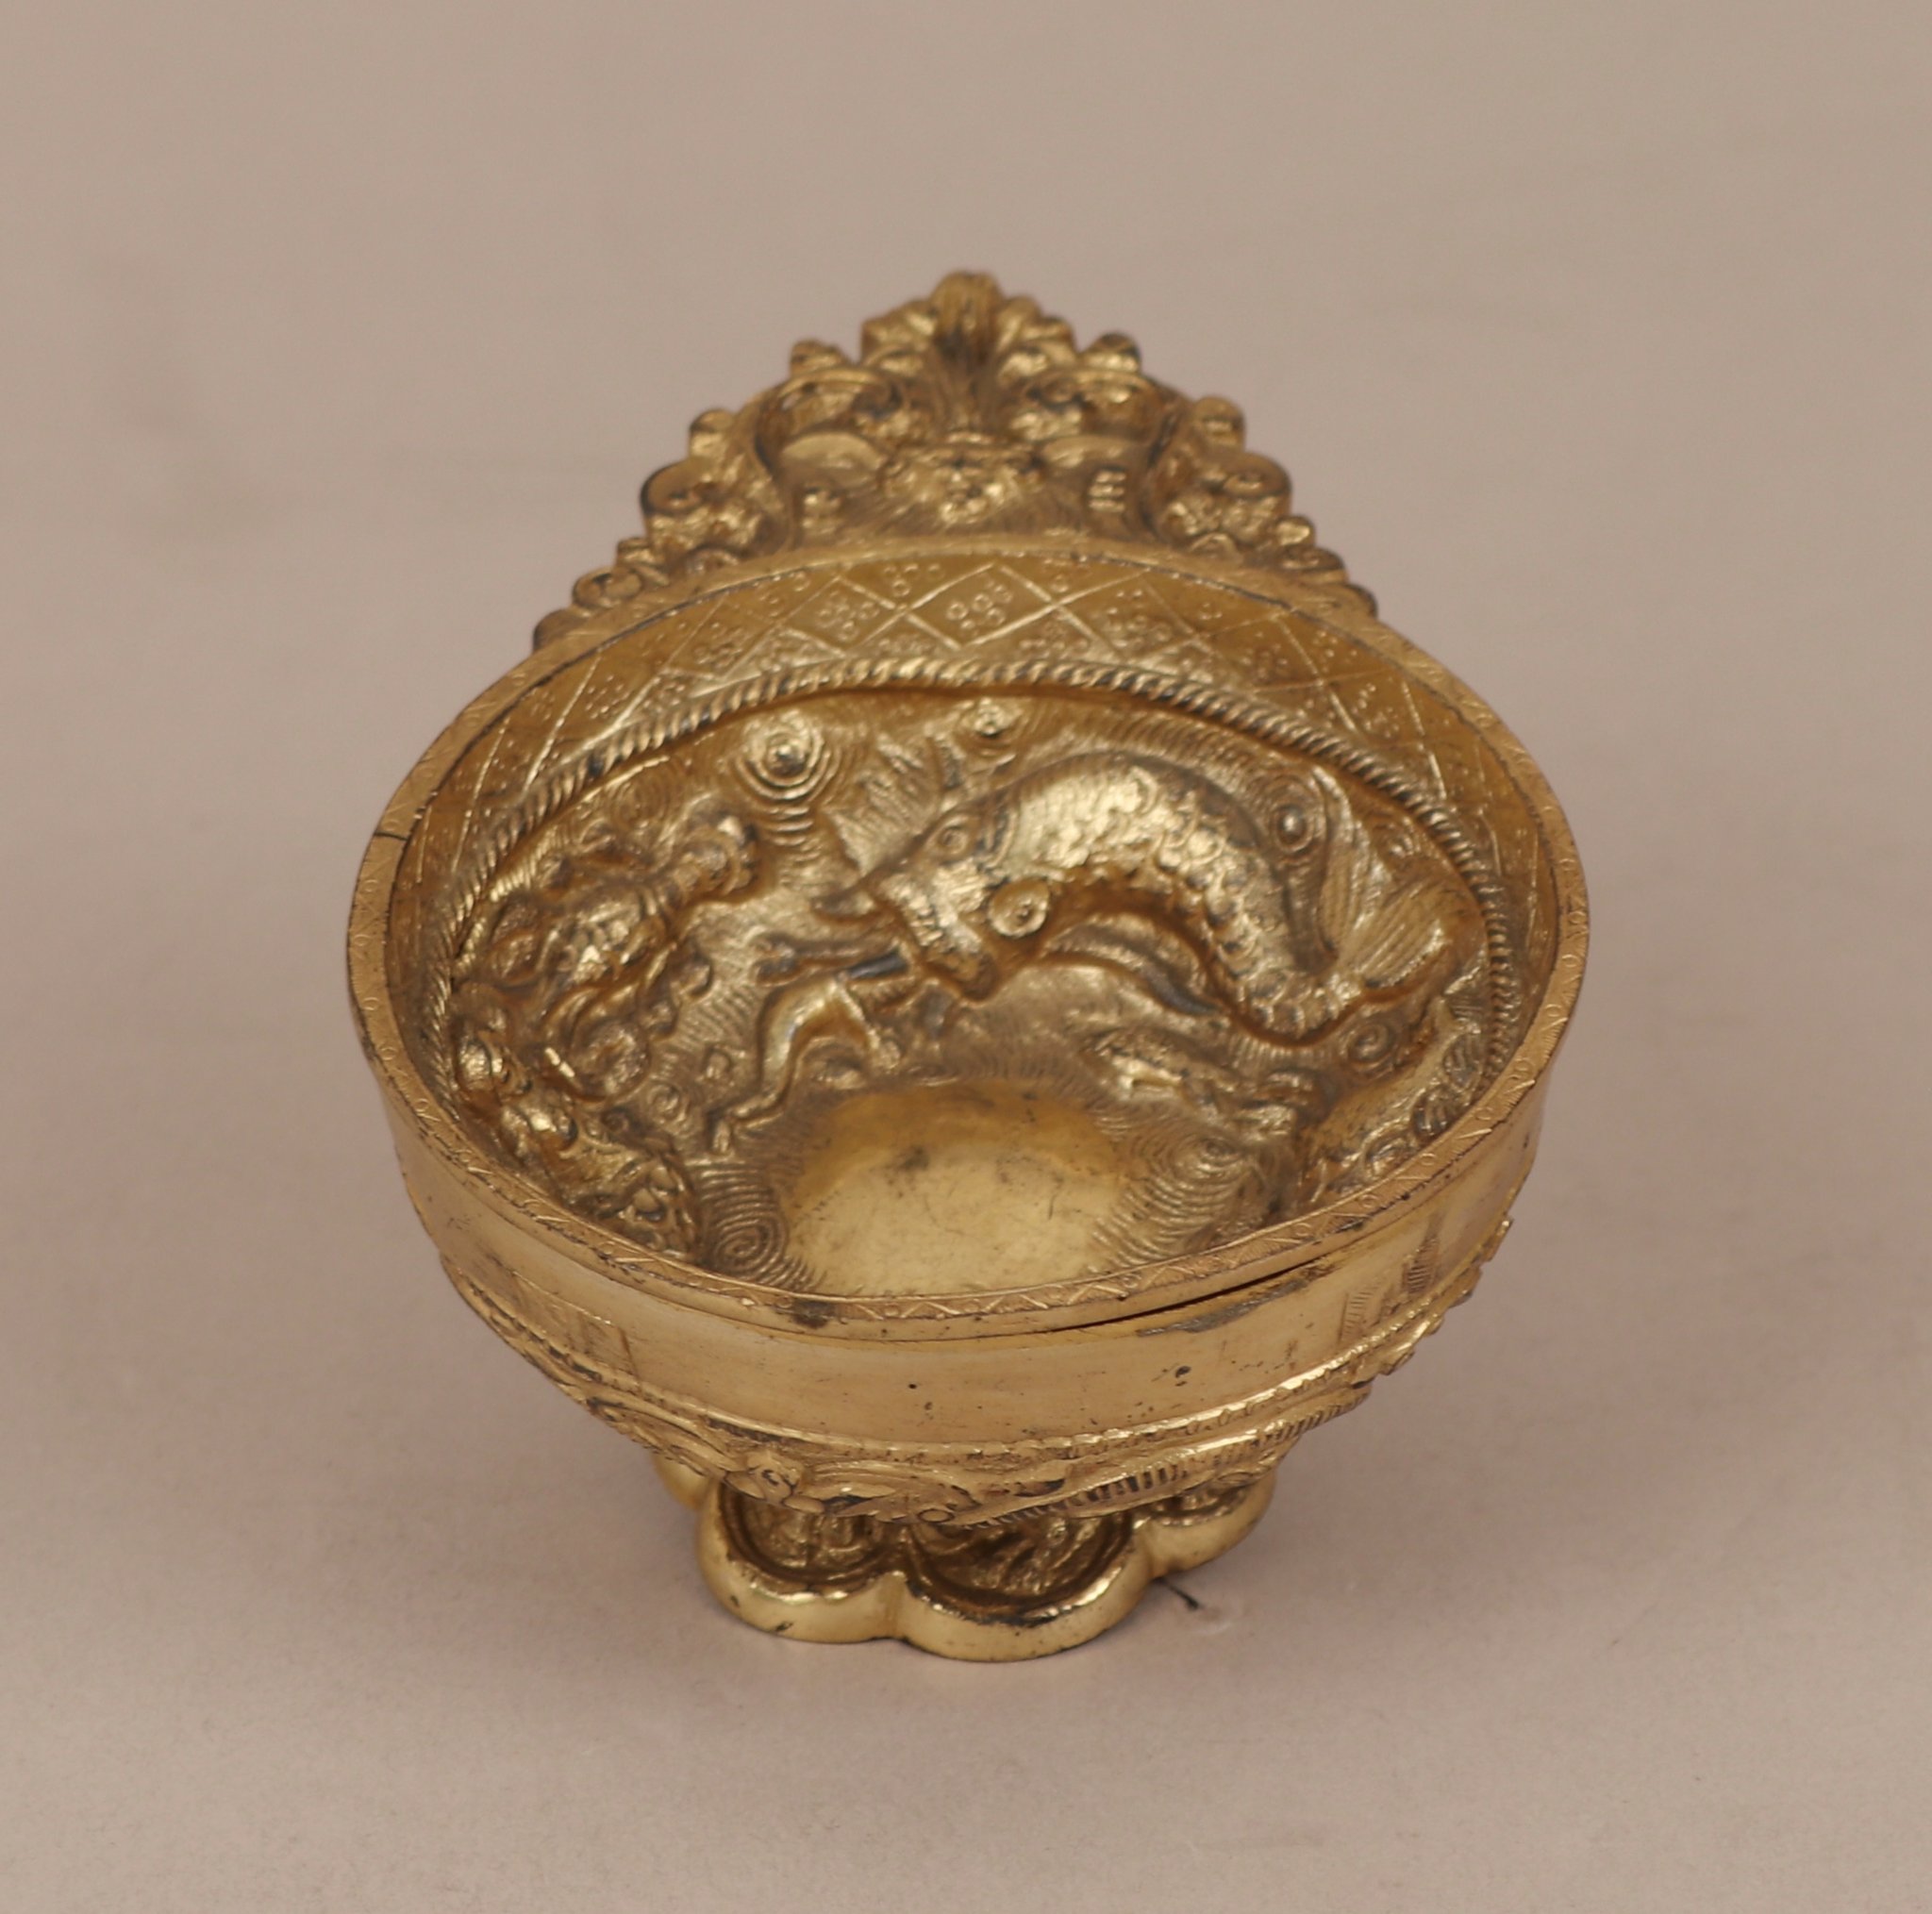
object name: cup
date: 1801-1900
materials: metal, silver